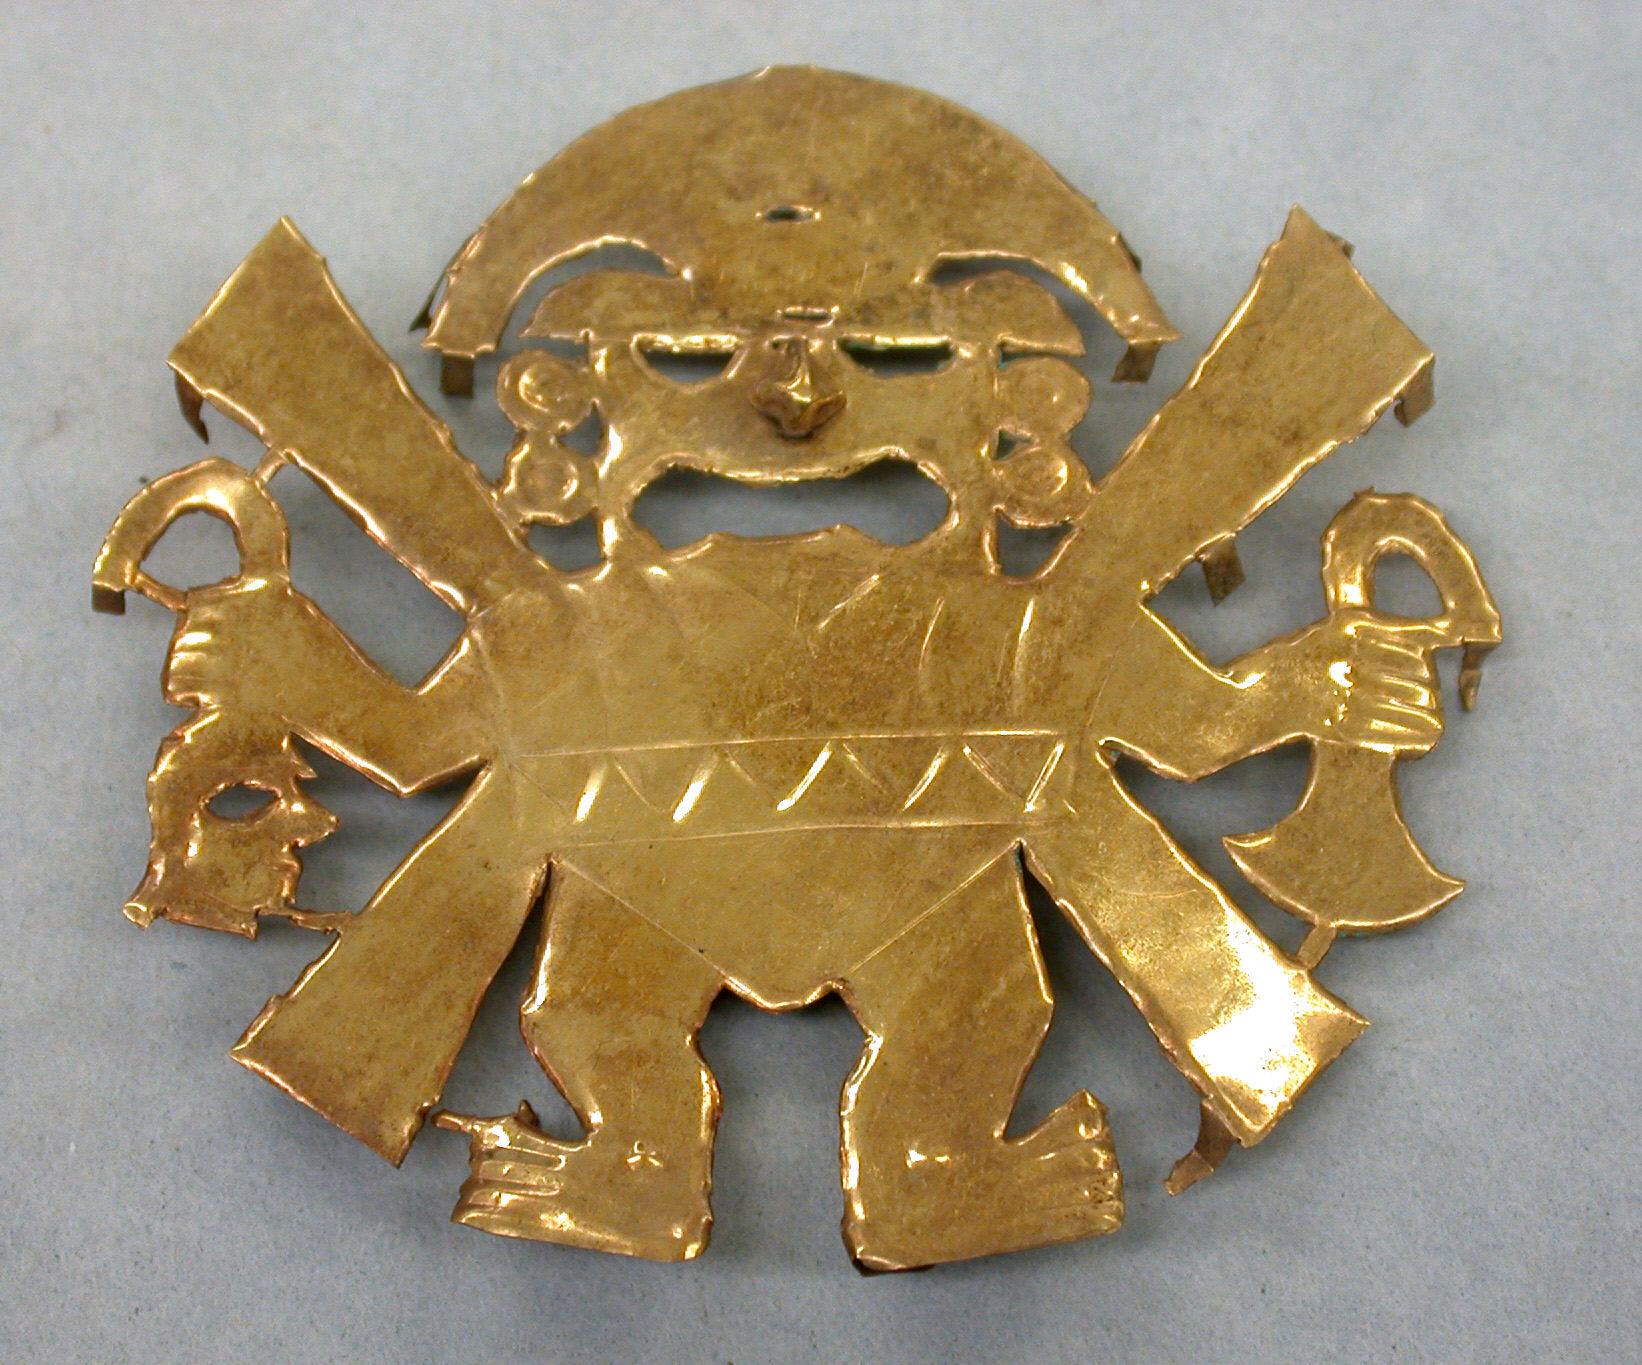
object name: earflare frontal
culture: moche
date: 501-700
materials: gold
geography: peru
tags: human figures